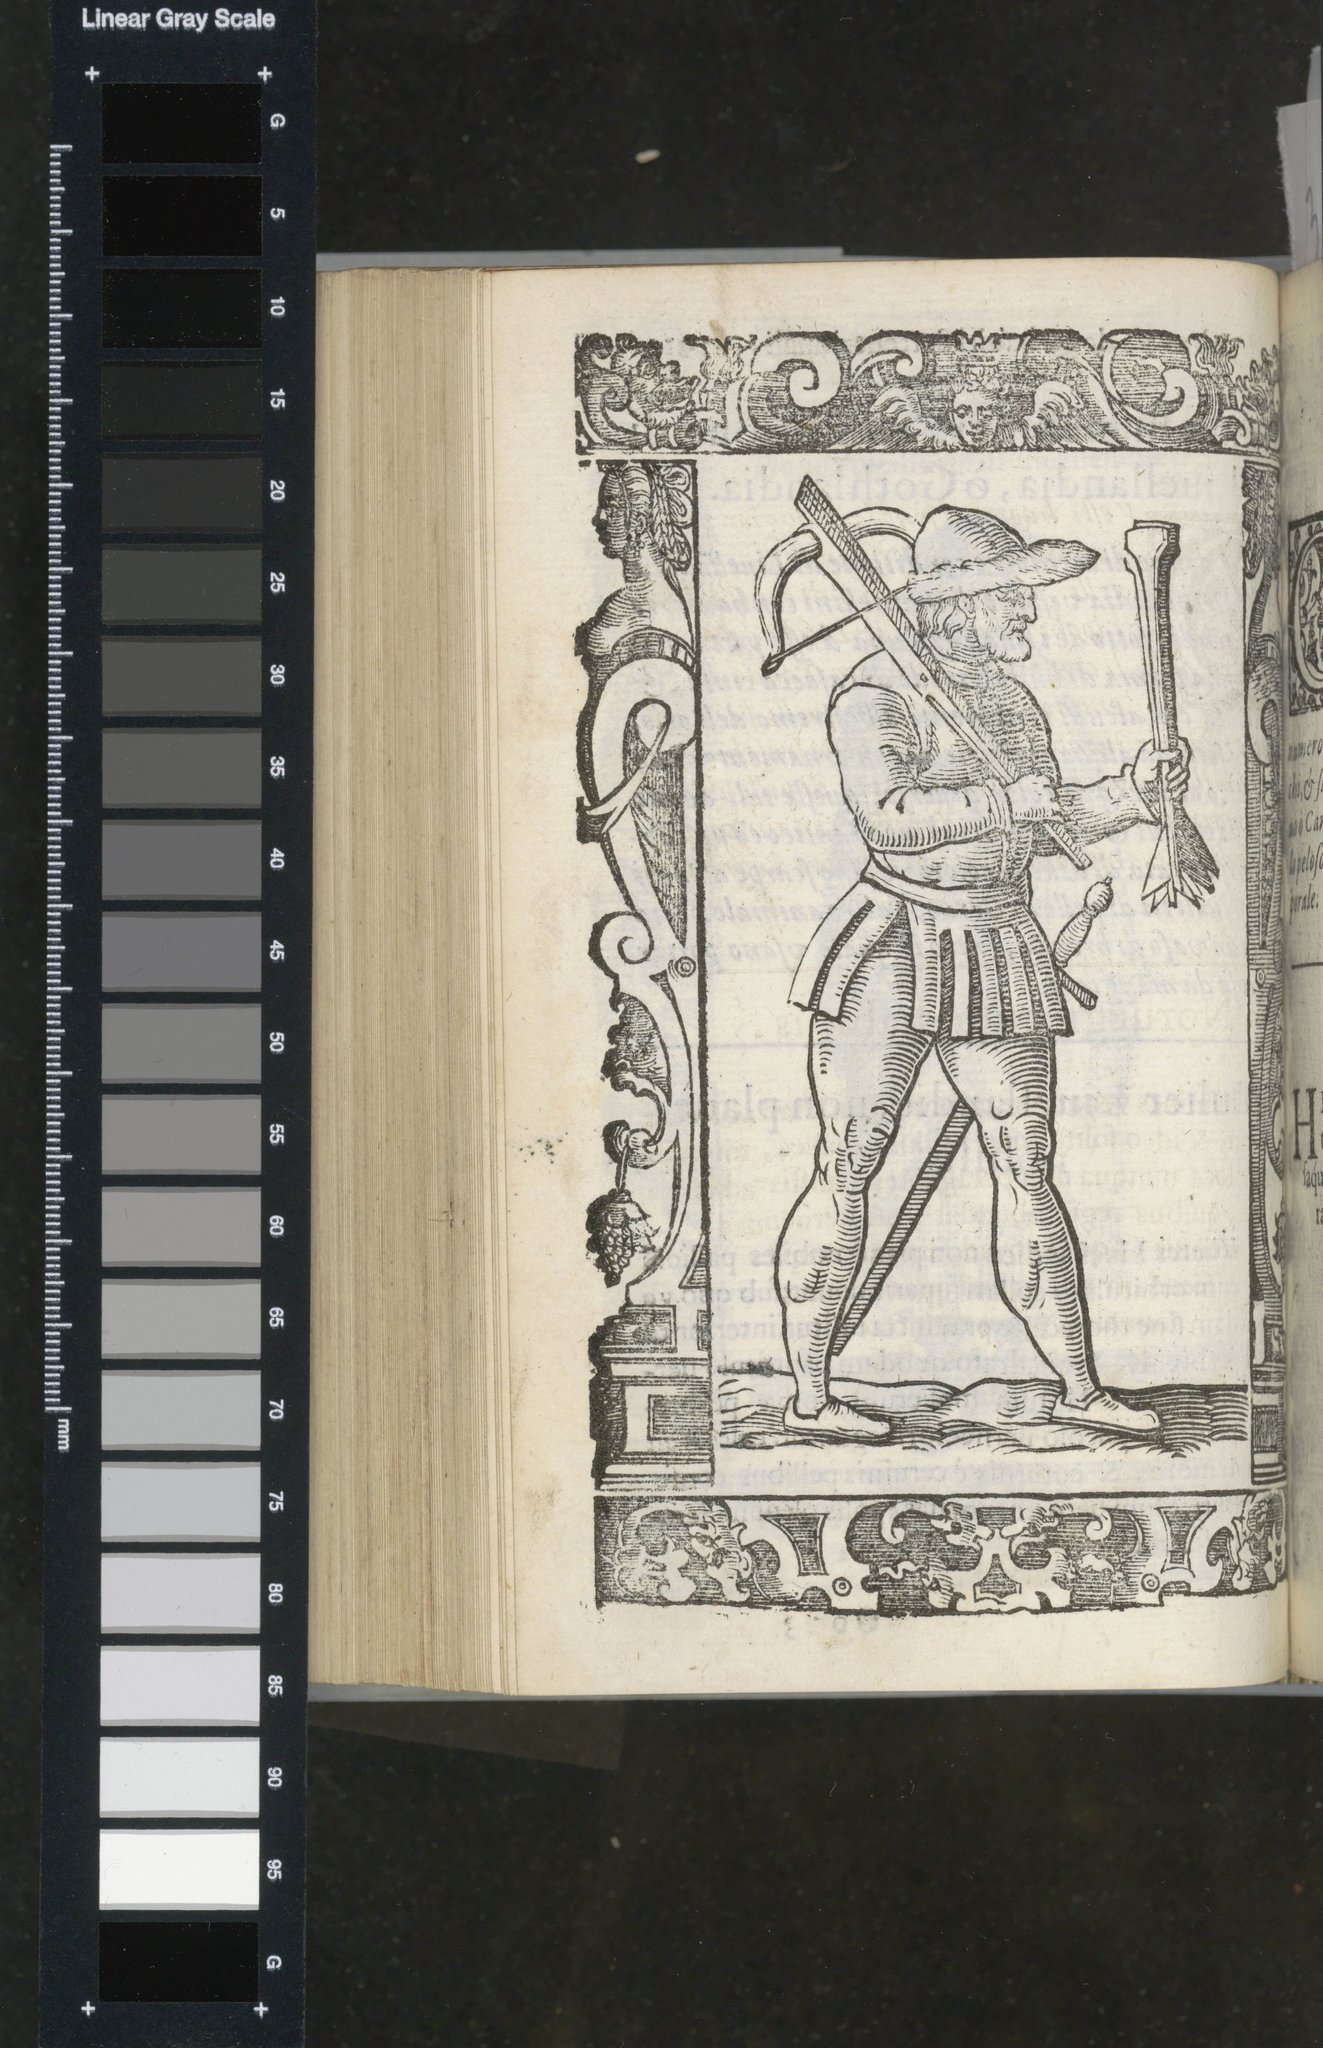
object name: costume print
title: Habito di Norvegia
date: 1598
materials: paper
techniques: woodcut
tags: fashion plates